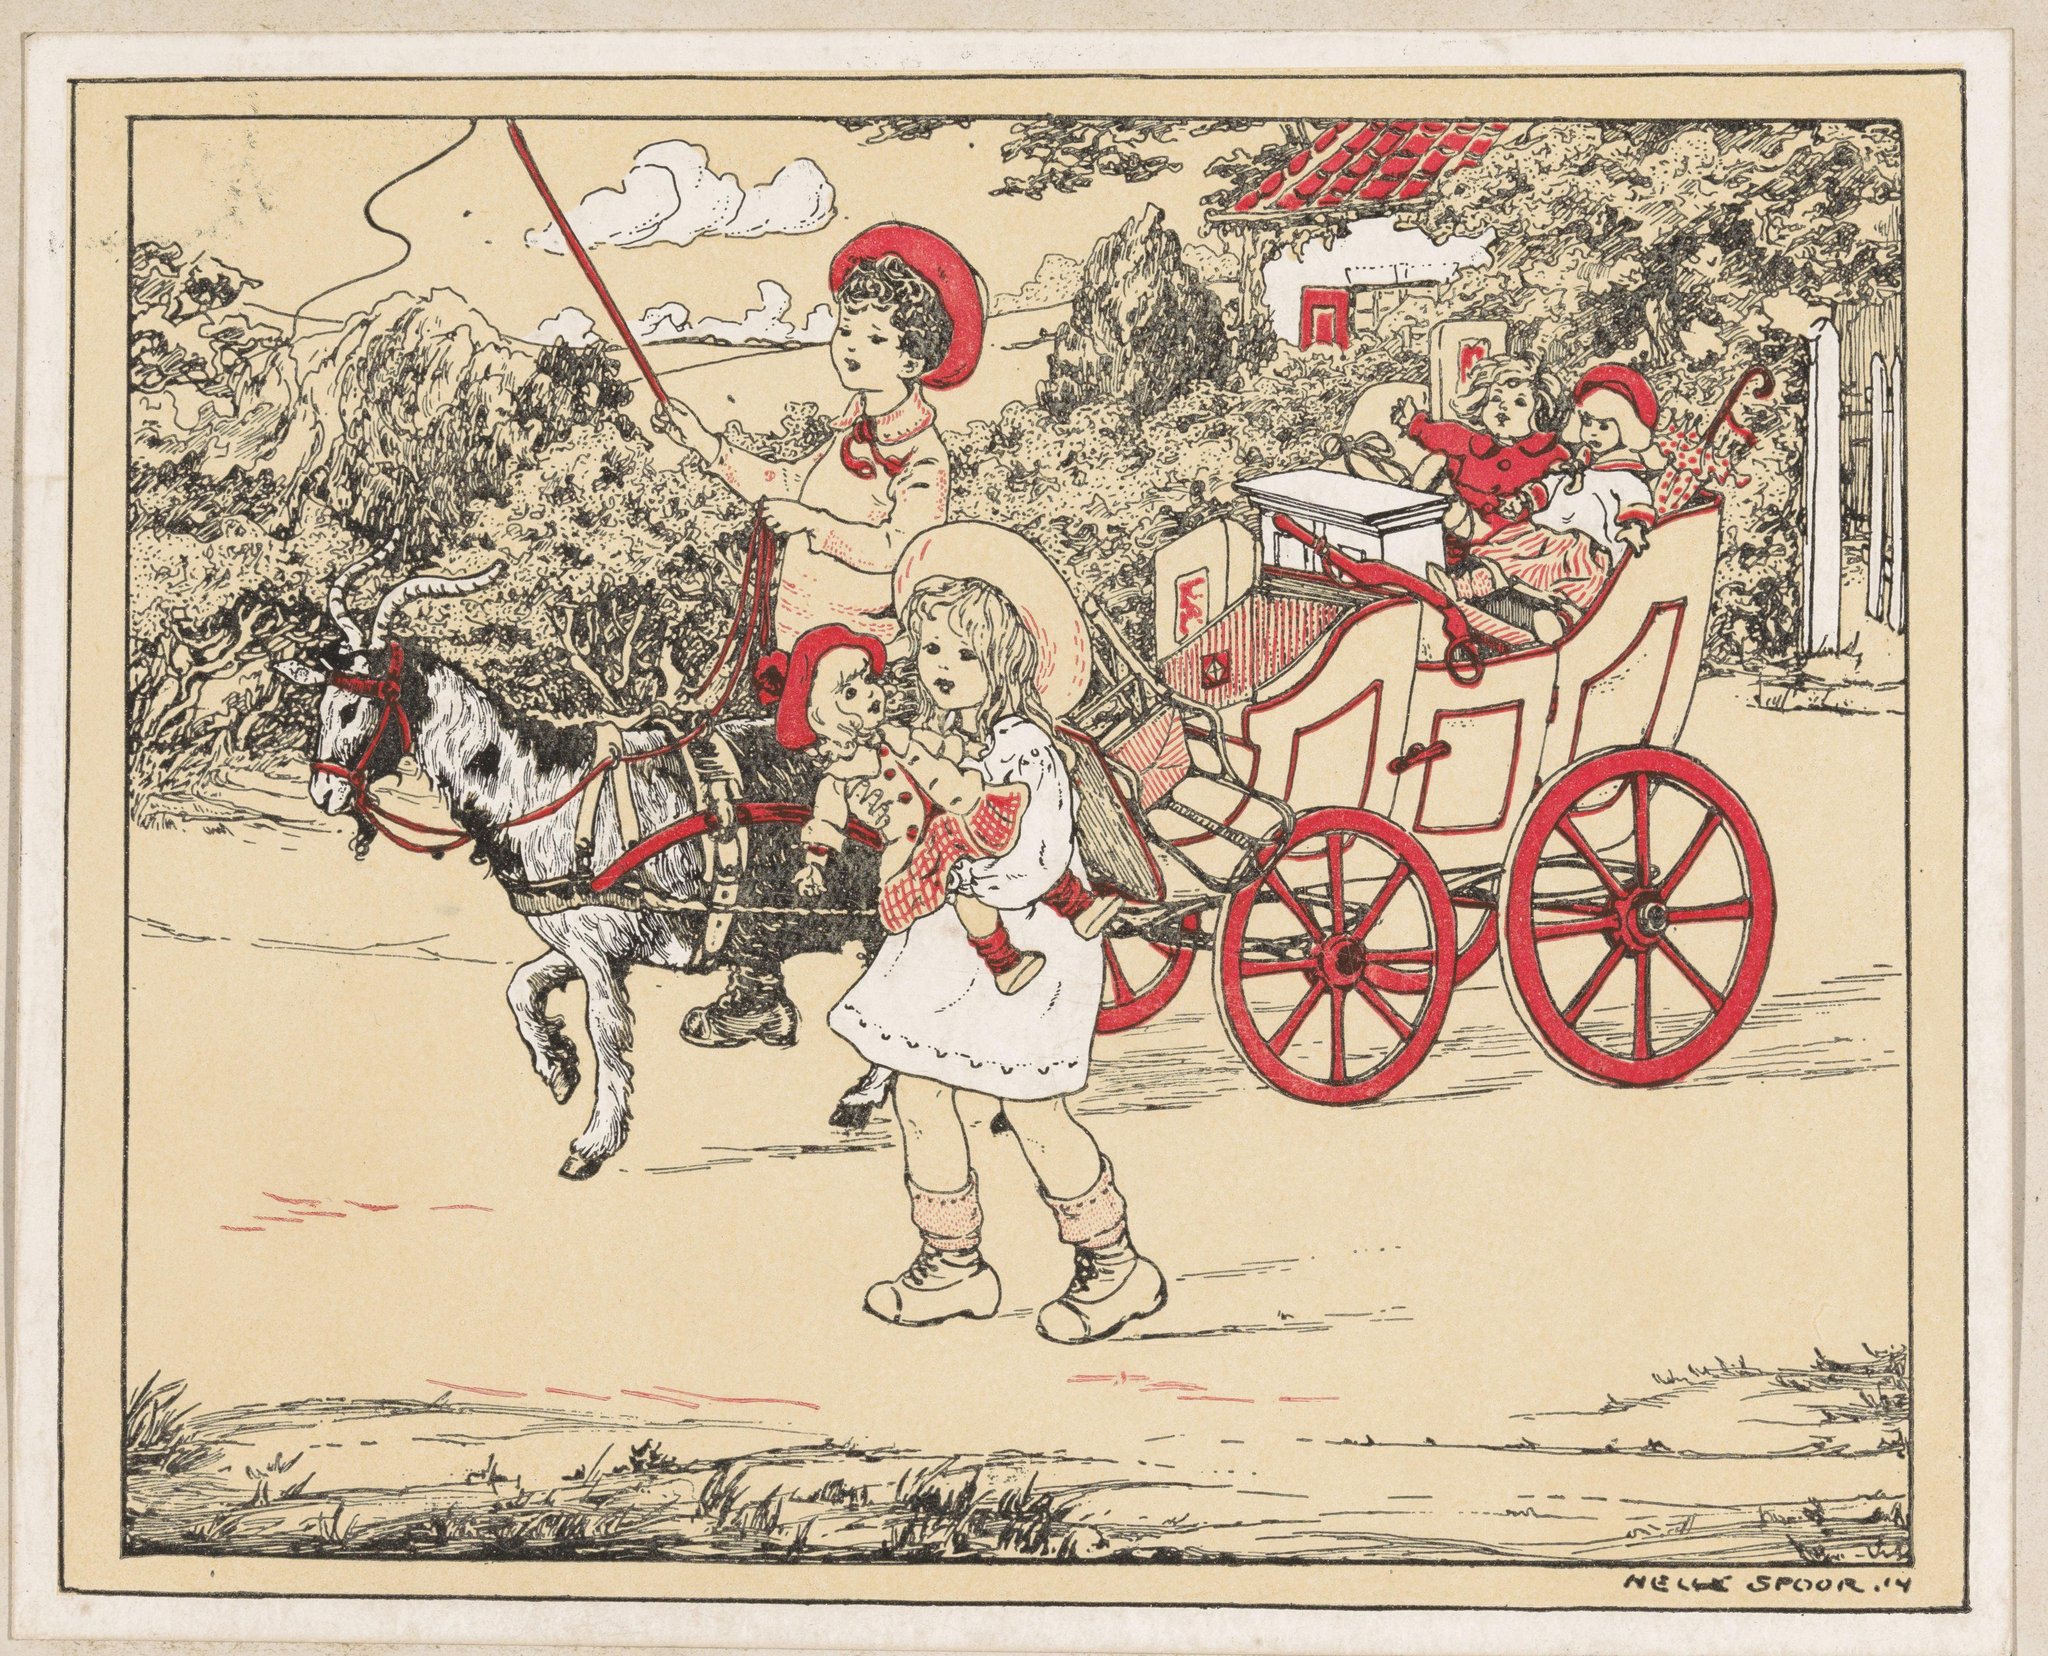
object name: boekillustratie ontwerp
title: Jongen bestuurt een poppenkoets op een geit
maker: Anonymous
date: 1914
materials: cardboard, paper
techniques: photochemical processes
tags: animal traction, animal-drawn vehicle (carriage etc.), (playing with) dolls, goat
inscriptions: collector's mark: Lugt 2228, signature and date: ‘NELLY SPOOR. 14’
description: Op een pad voor een huis zit een jongen op een geit met een zweep in de hand. De geit trekt een koets voort waarop twee poppen zitten. Een meisje met een pop loopt met de koets mee.